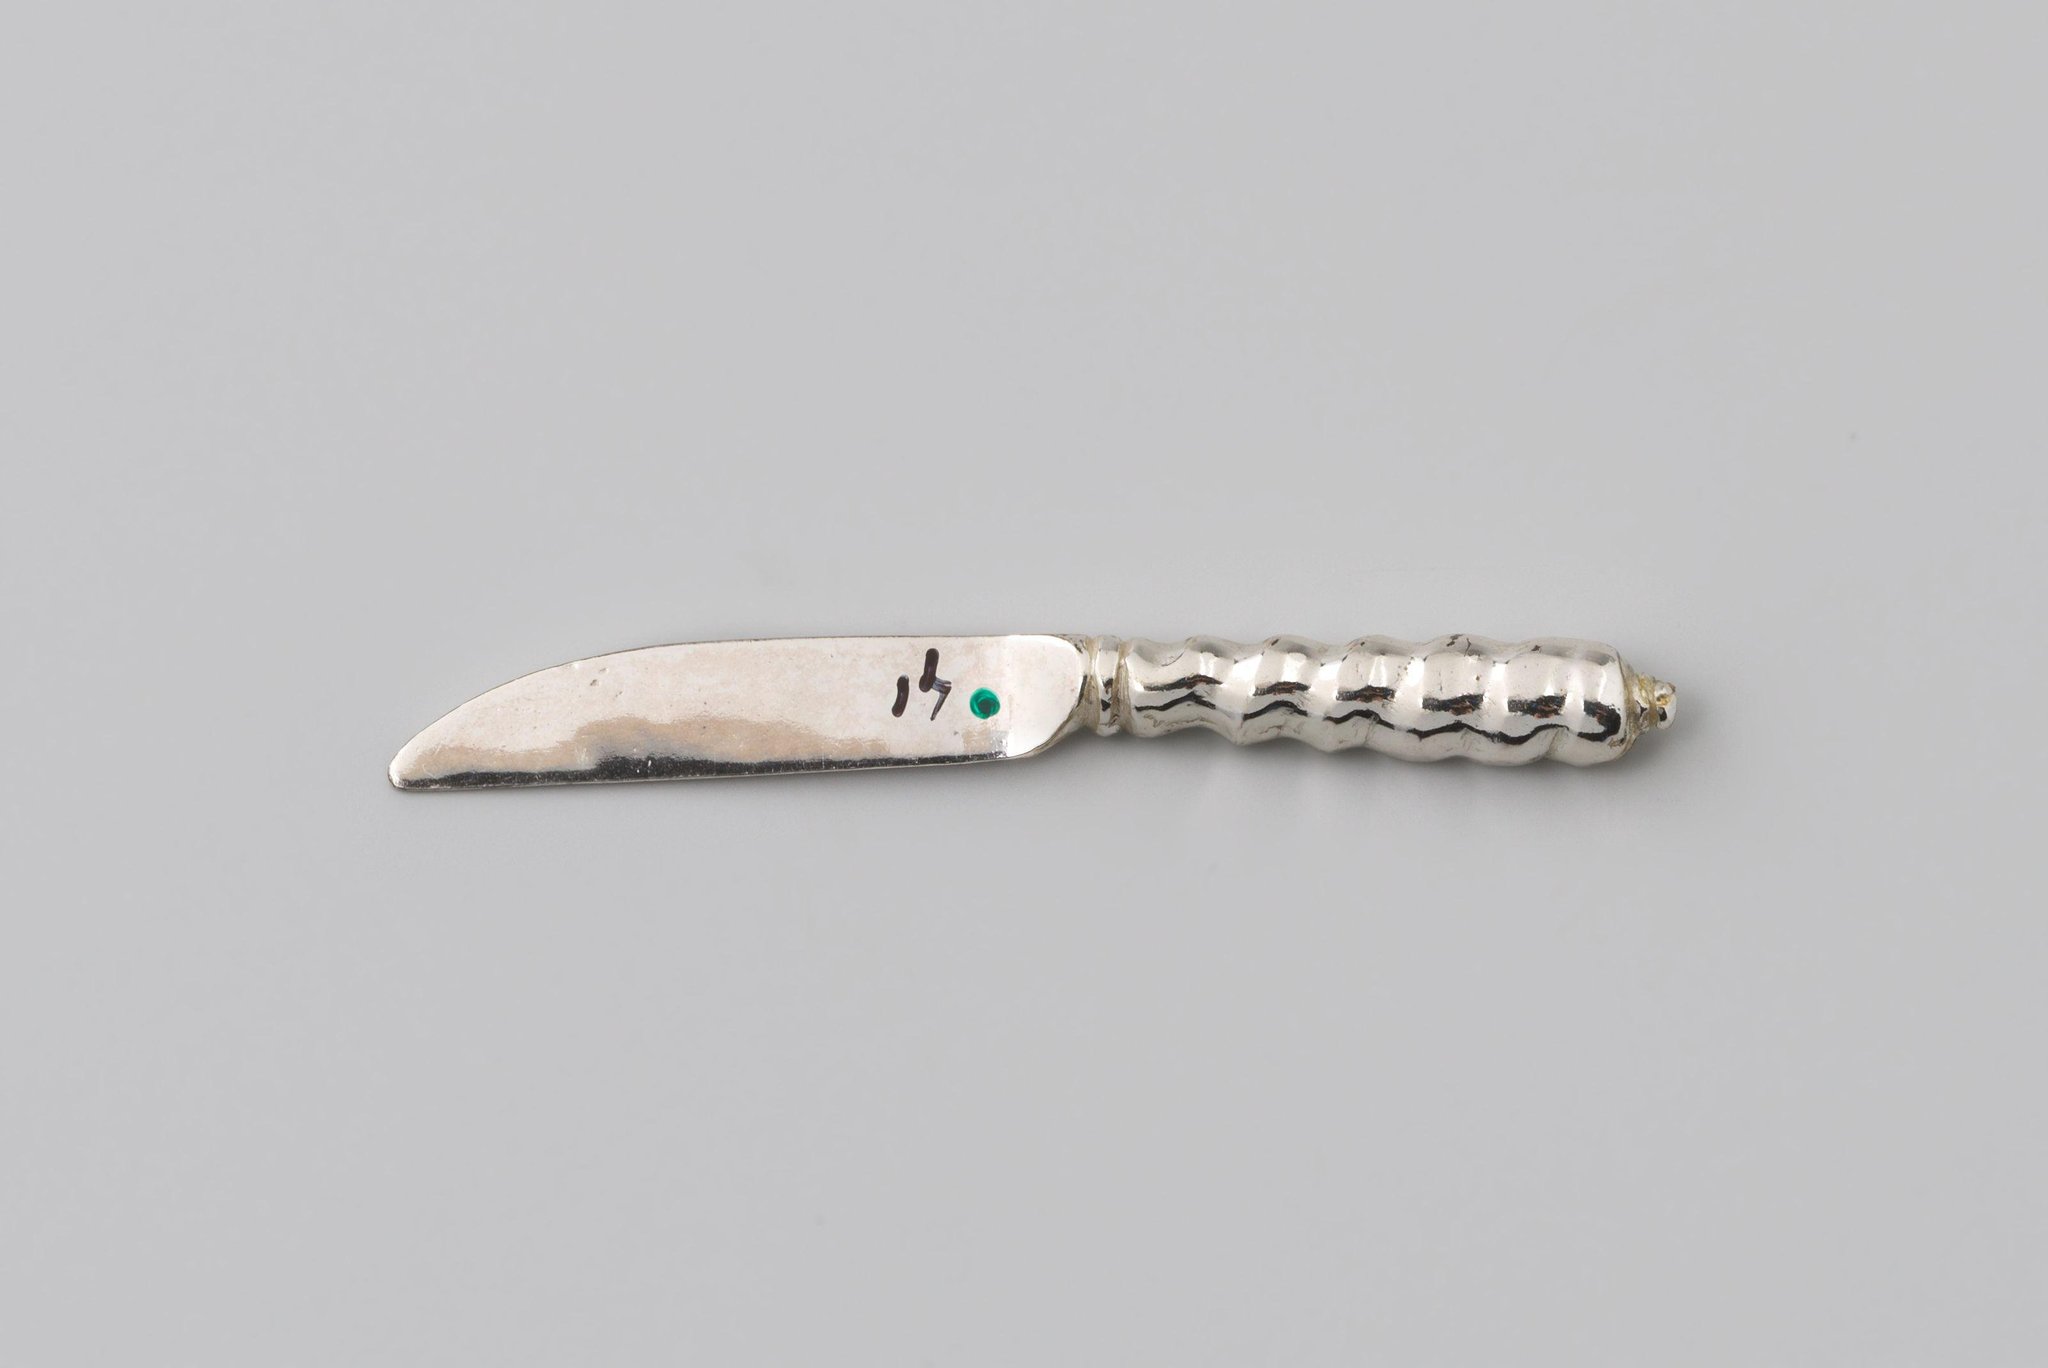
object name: miniature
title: Tafelmes van zilver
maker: Anonymous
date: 1814-1906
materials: silver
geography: netherlands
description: Tafelmes van zilver met getorst heft en puntig lemmet.